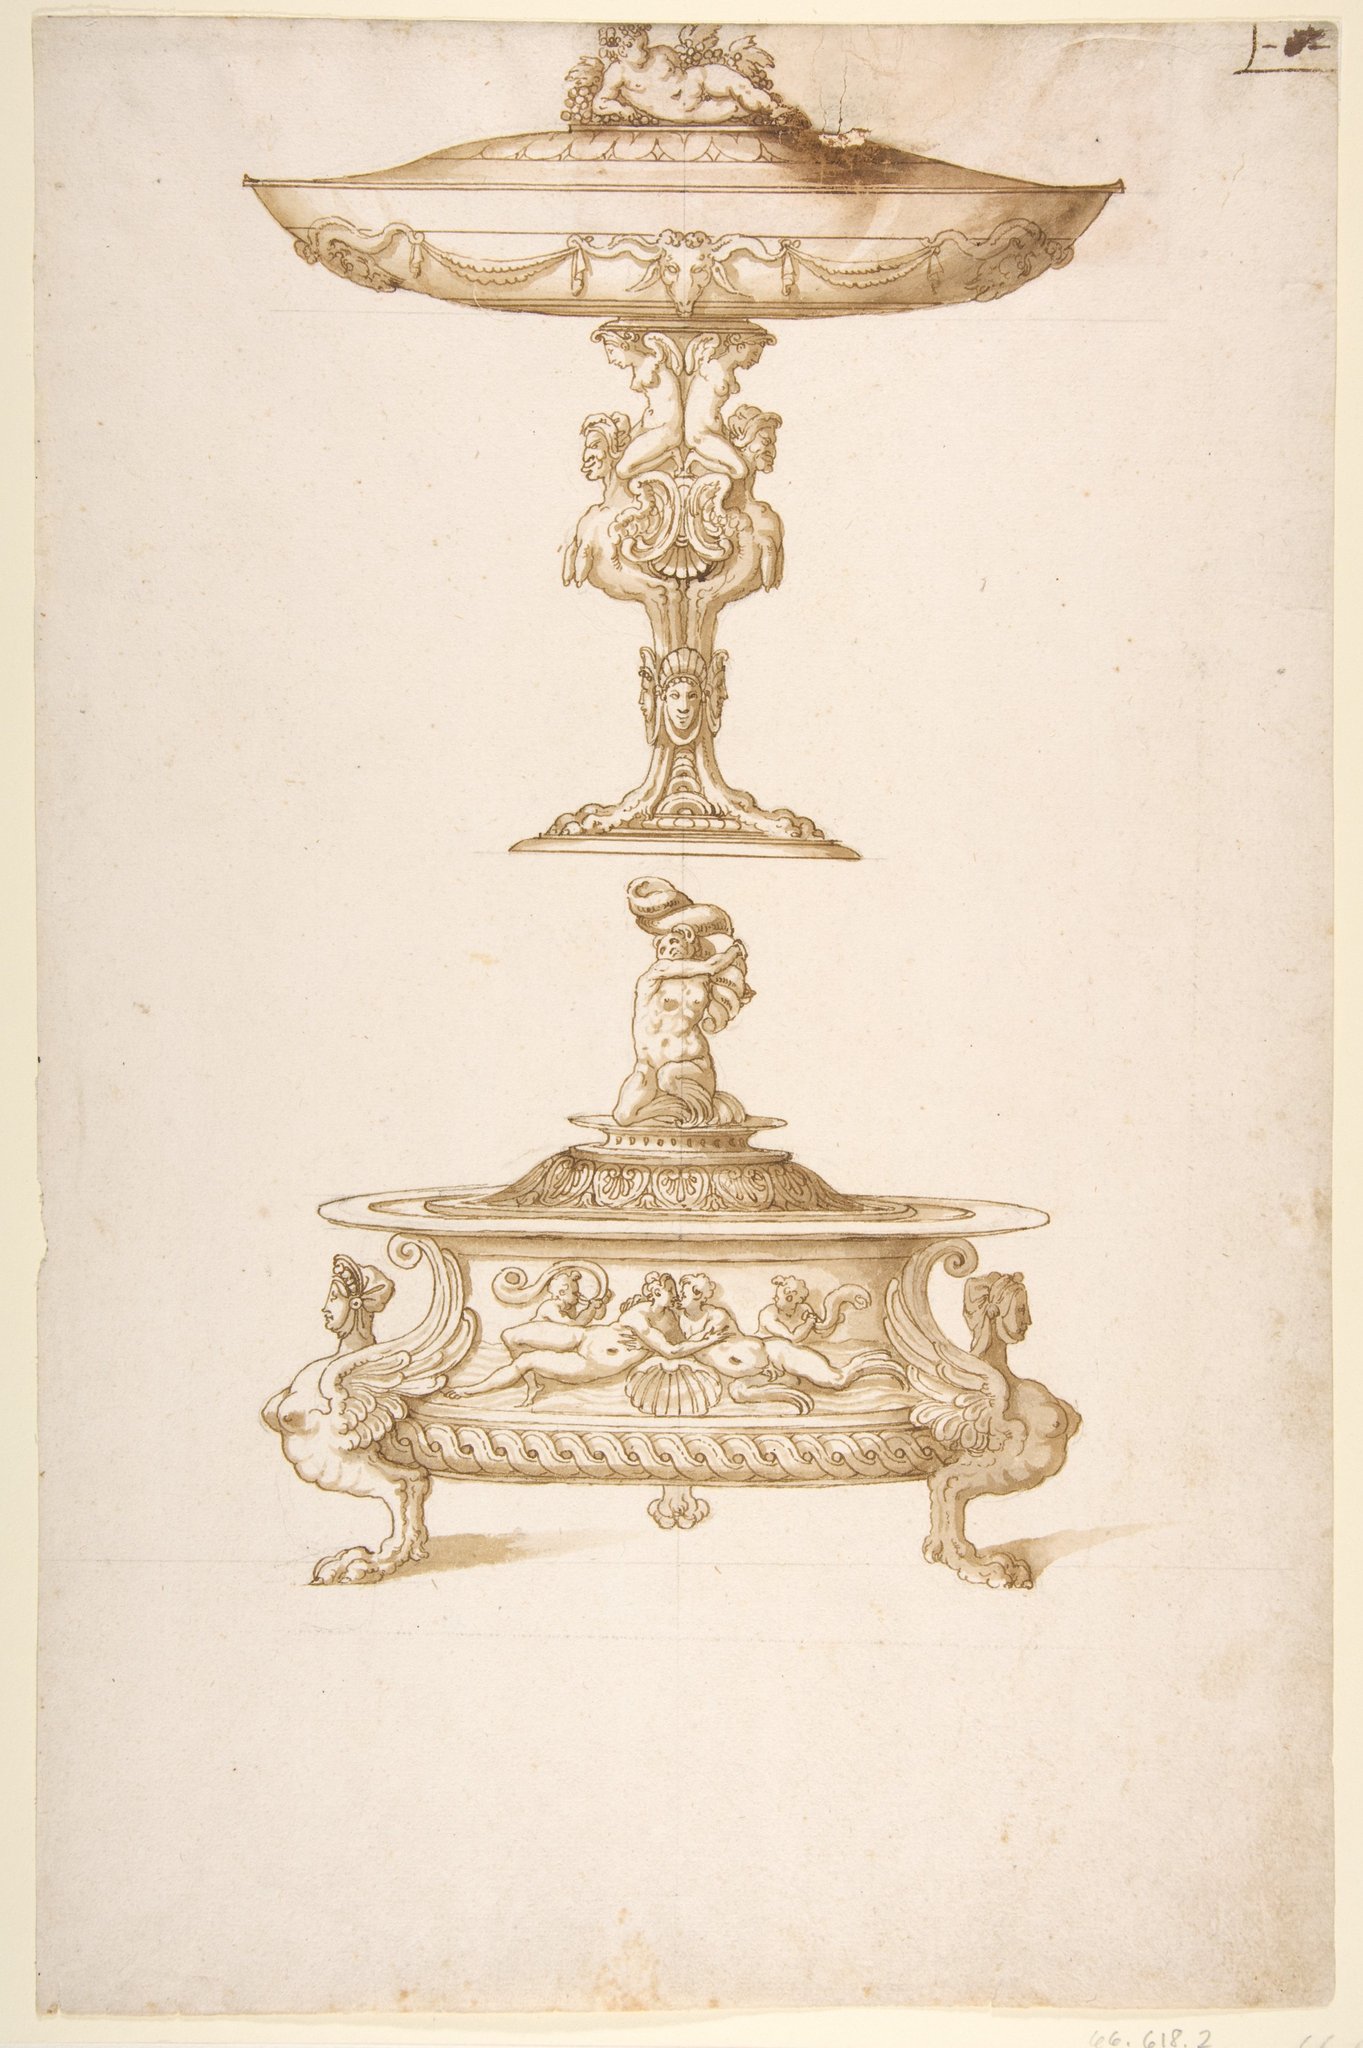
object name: drawing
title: Design for a Salt Cellar and Tazza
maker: ottavio strada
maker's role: artist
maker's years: 1550-1606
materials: chalk, ink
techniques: brush, pen, wash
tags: vessels